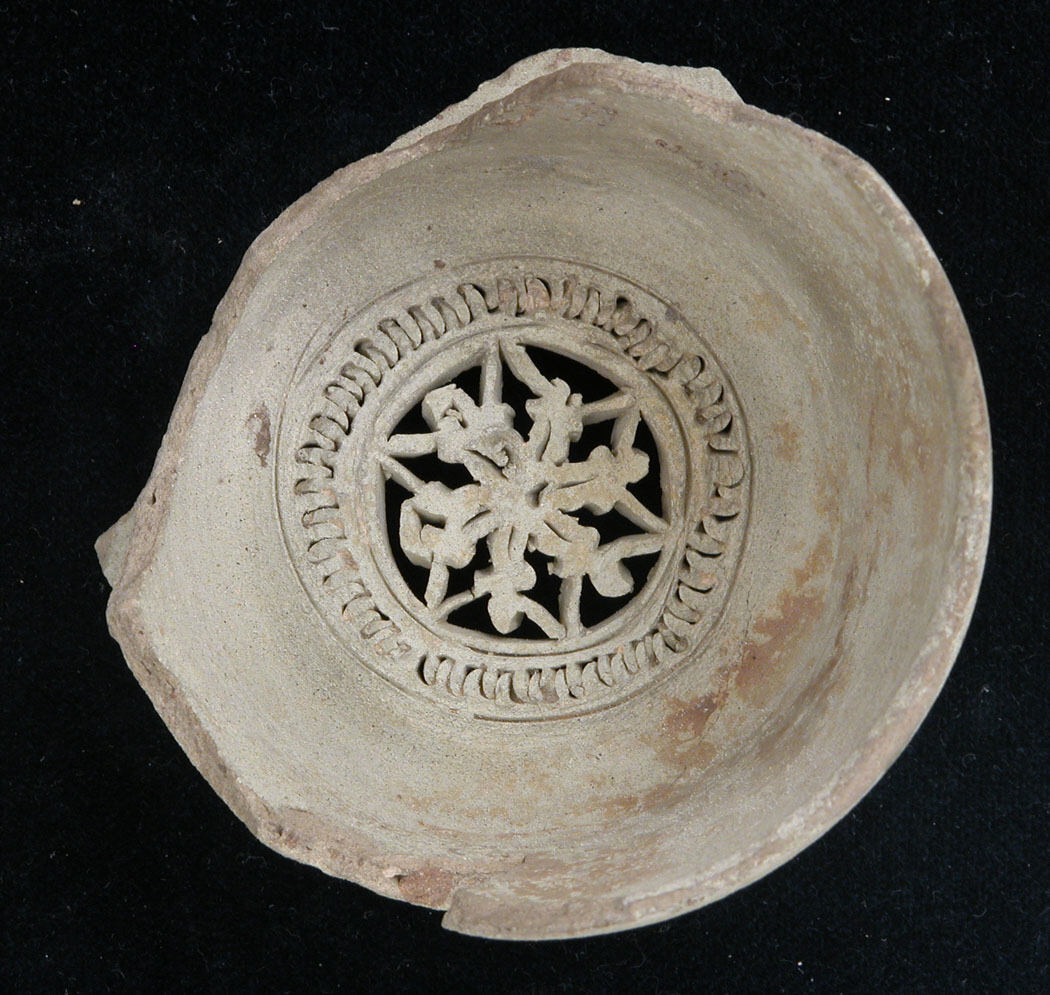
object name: water filter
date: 901-1200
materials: earthenware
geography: egypt